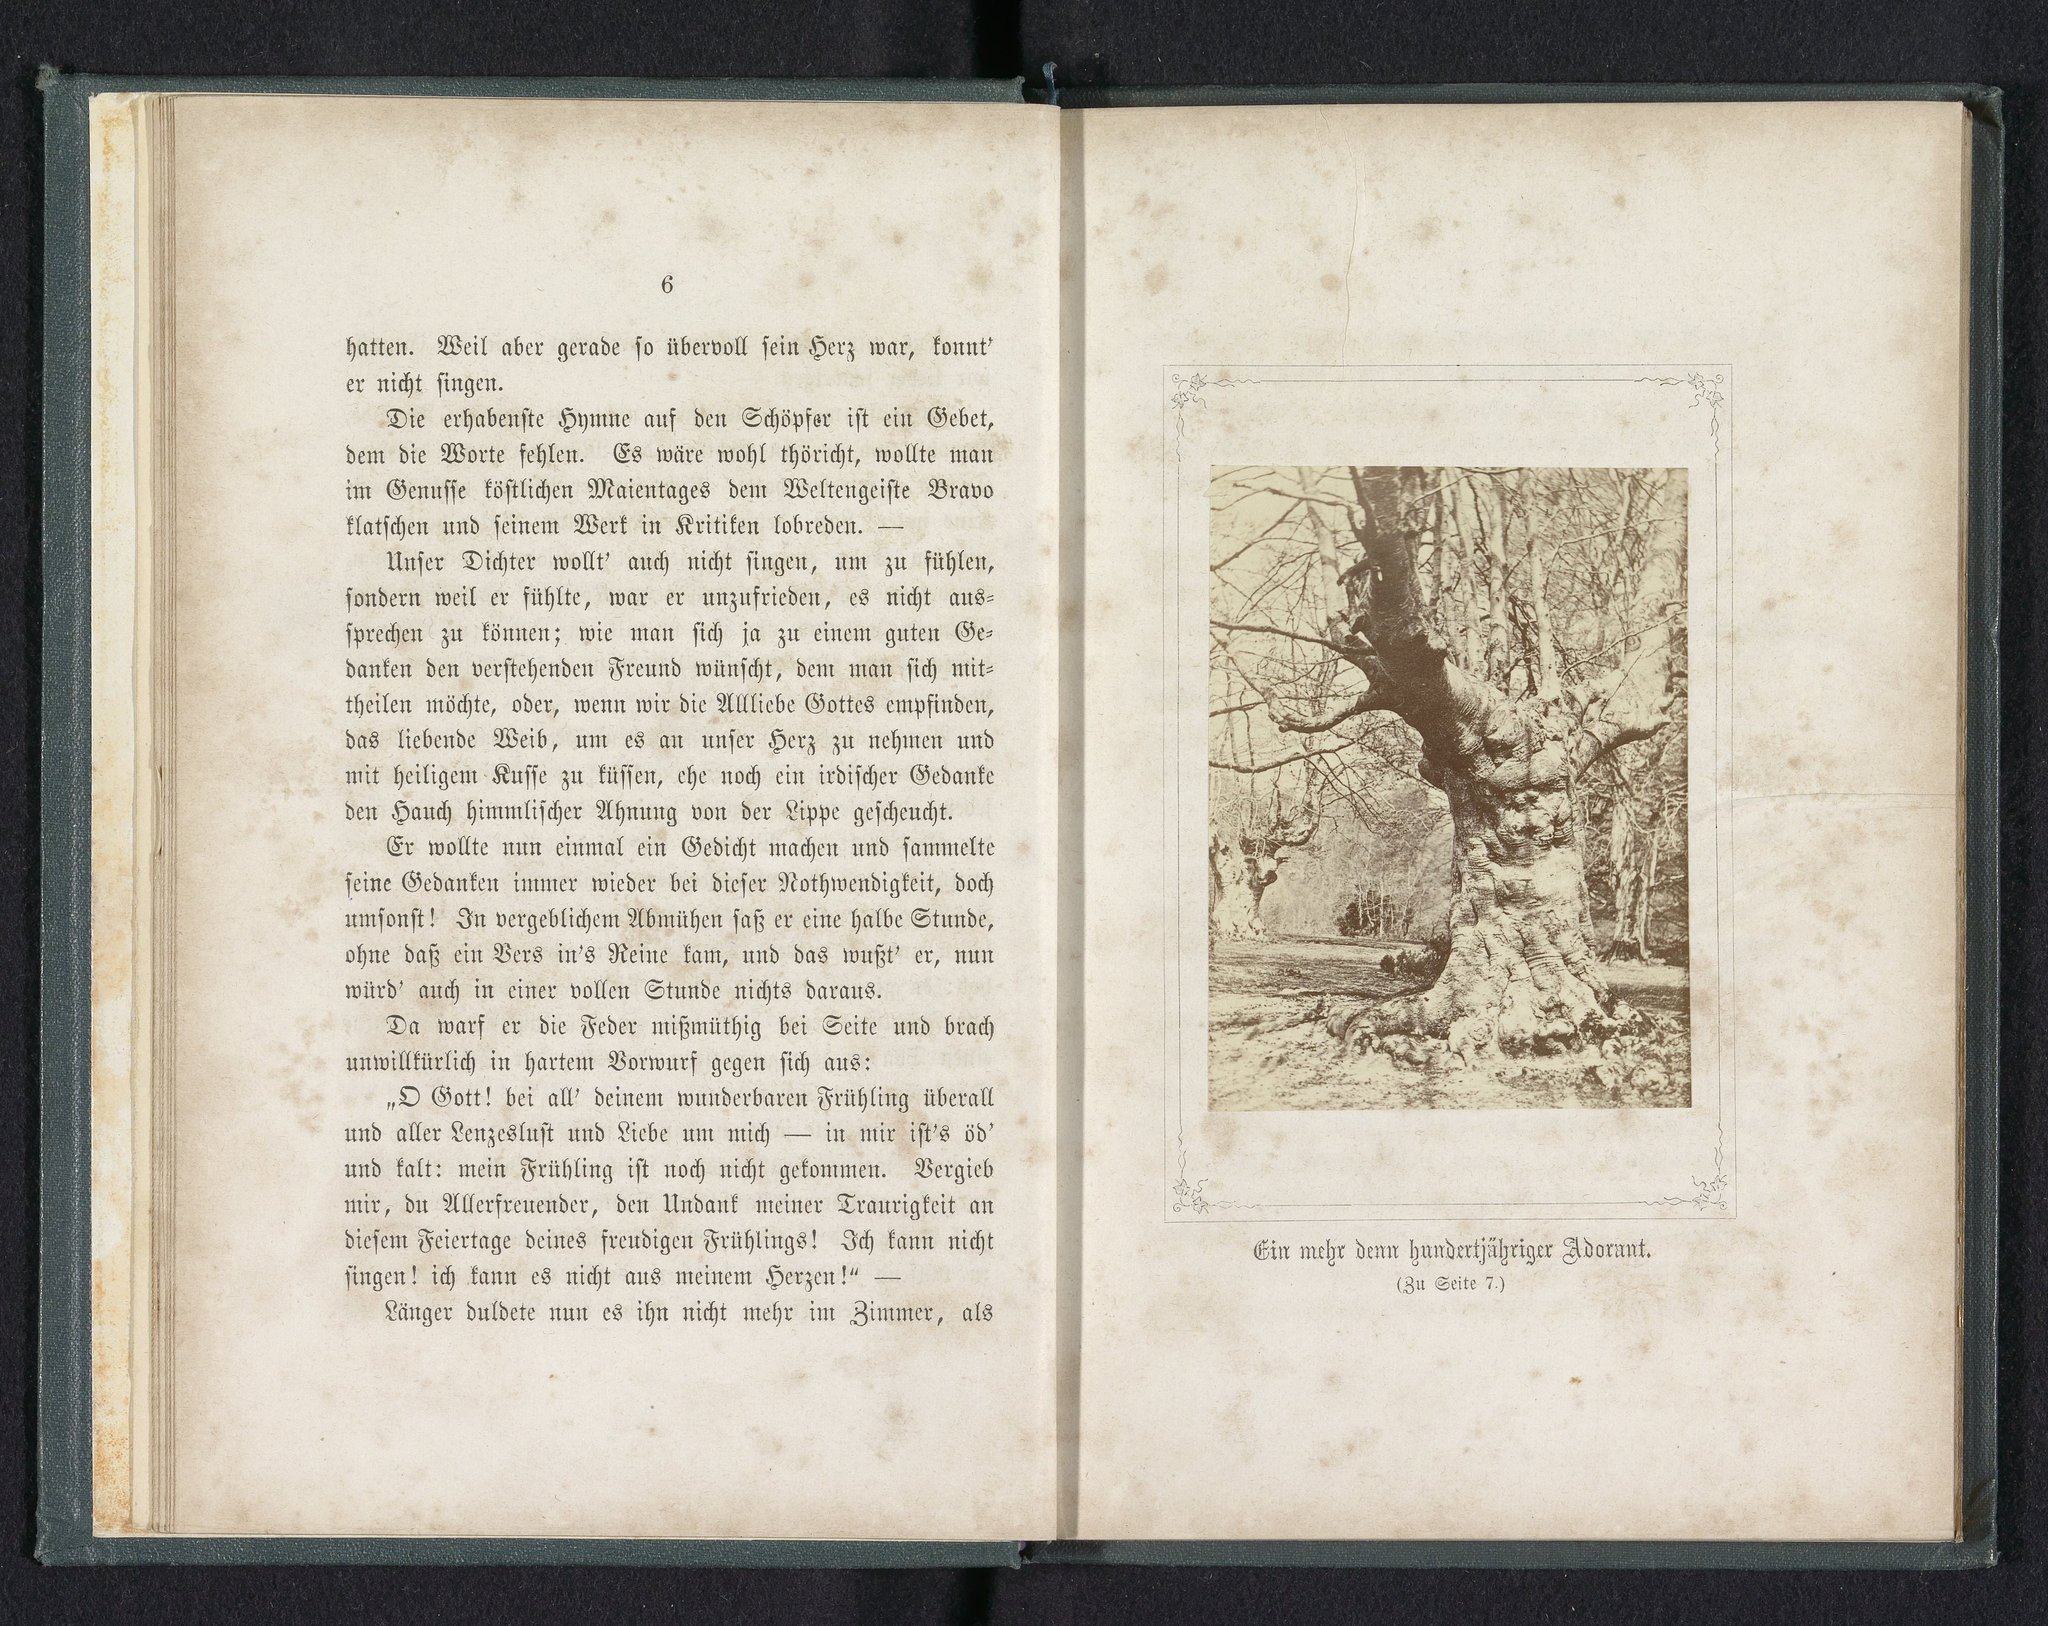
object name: photograph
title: Ein mehr denn hundertjähriger Adorant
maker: Anonymous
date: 1852-1862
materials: photographic support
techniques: albumen print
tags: trees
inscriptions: inscription: ‘(Zu Seite 7.)’